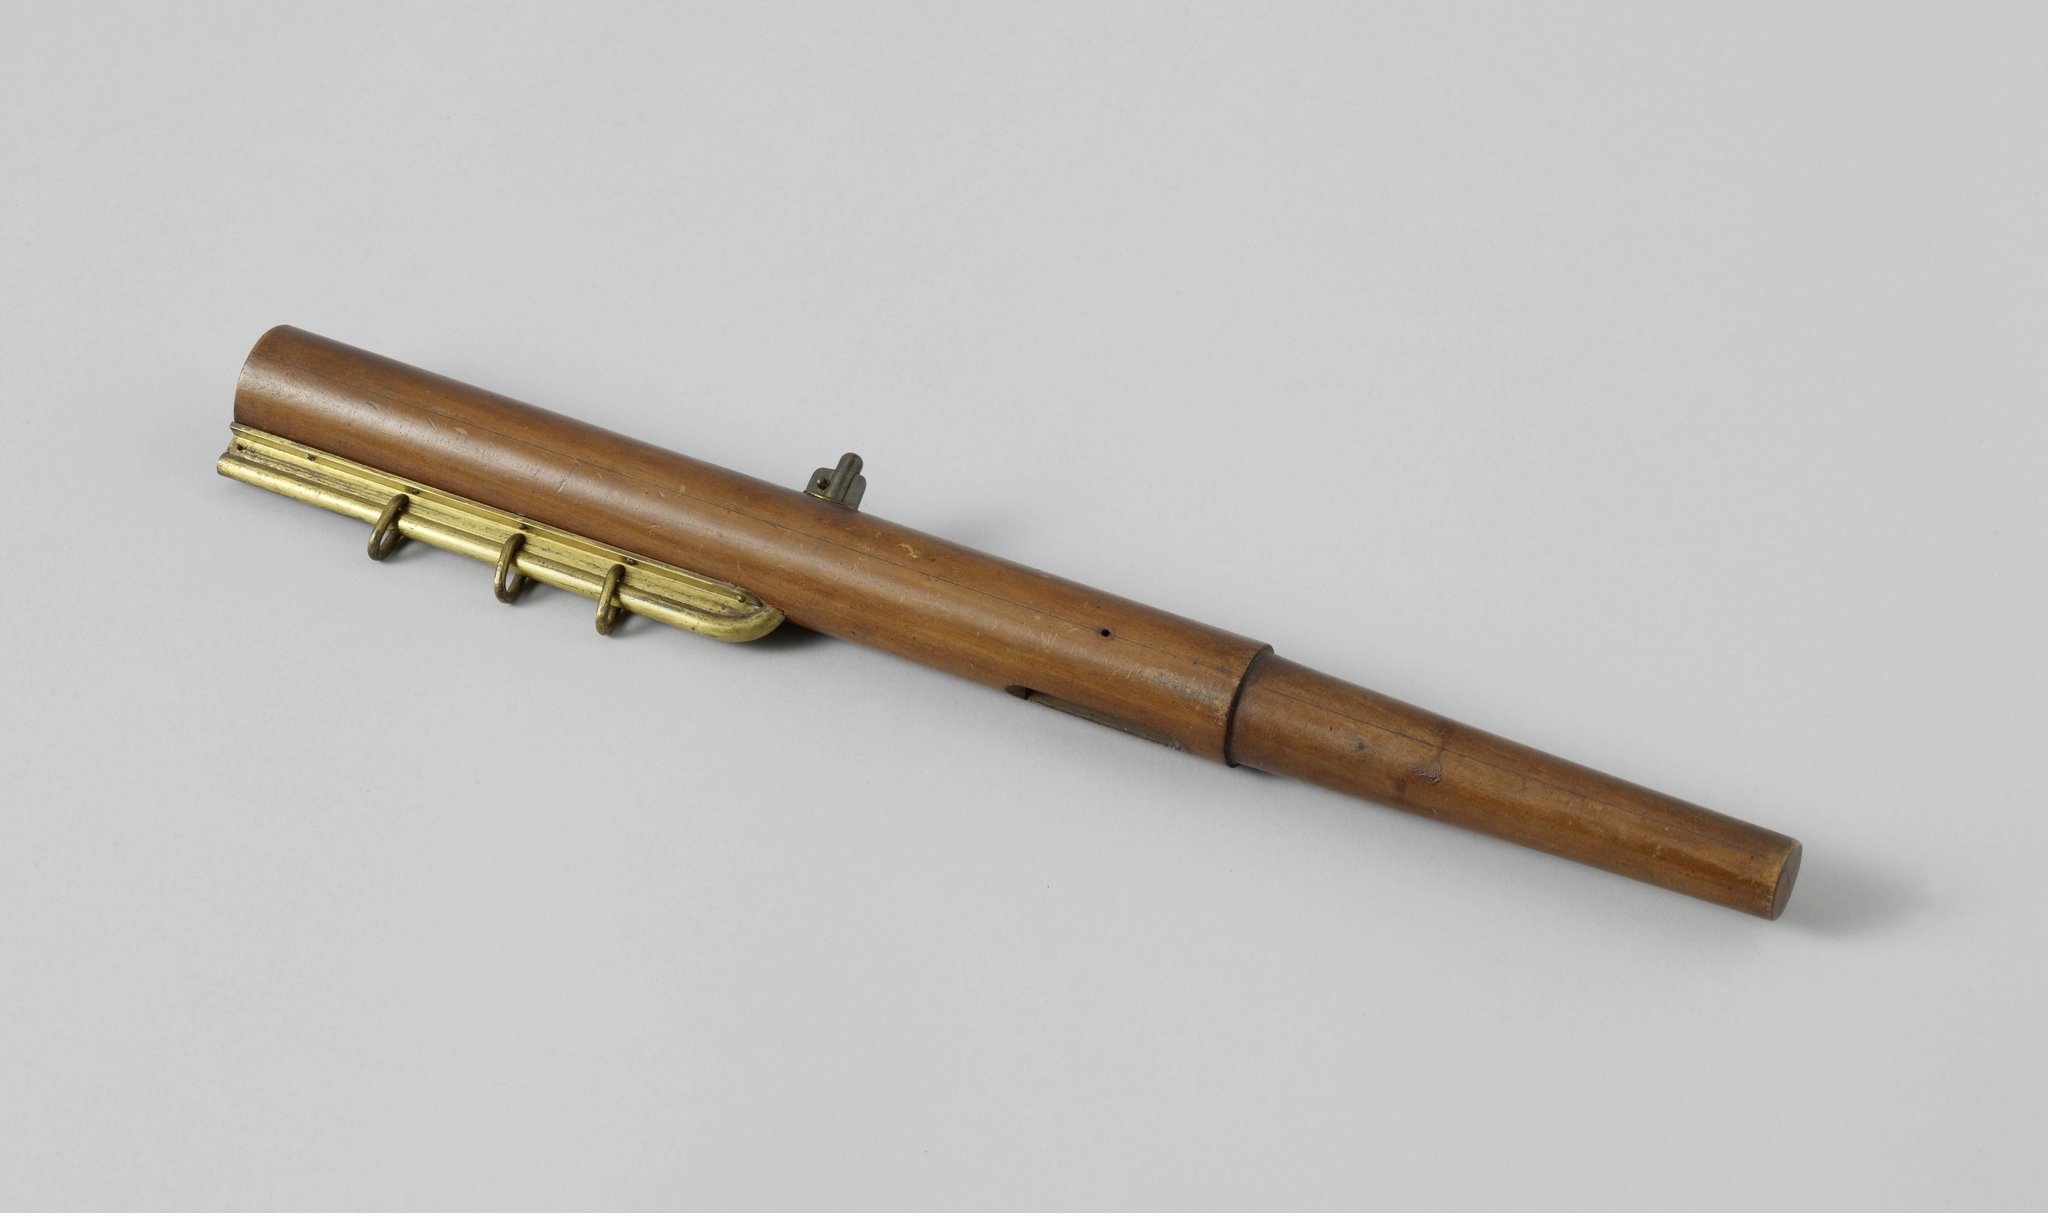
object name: demonstration model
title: Model of the End of a Gaff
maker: Anonymous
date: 1860-1870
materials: brass, wood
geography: netherlands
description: Model van de piek van een gaffel met een gat voor een schijf voor een nokval en tegen de onderkant een rail waarover ovalen ringen lopen. In de ringen werden de leuvers van het gaffelzeil geslagen. Deze inrichting was voor 'gordijnzeilen', die eenvoudig tegen de mast gegeid konden worden.